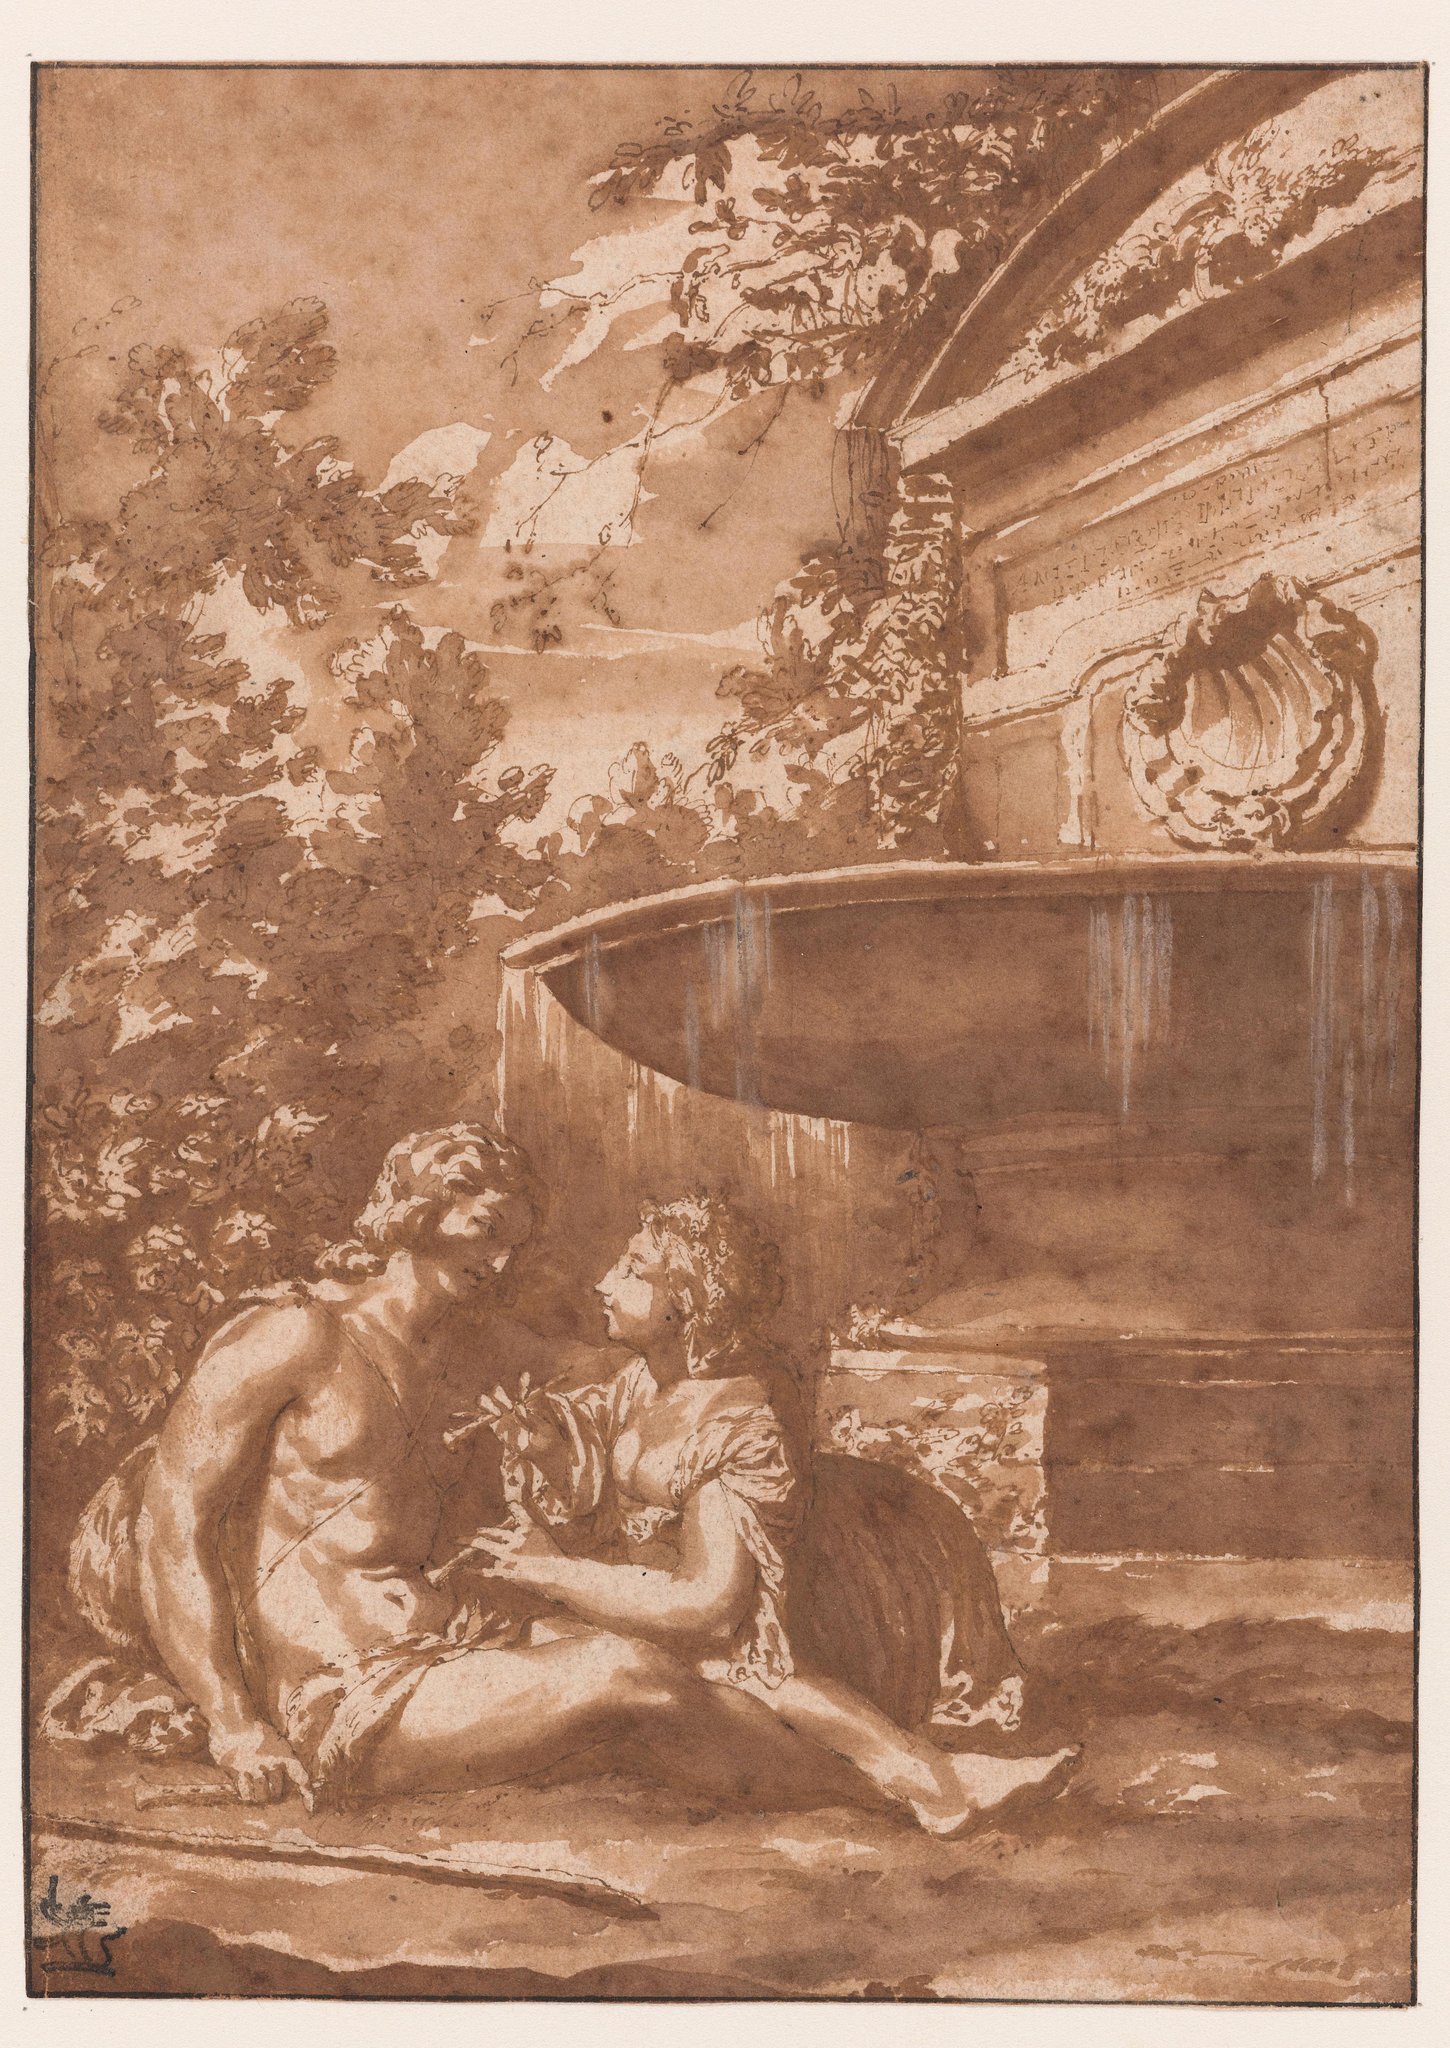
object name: drawing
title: Idylle bij een fontein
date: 1667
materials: ink, paper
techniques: brush, pen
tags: herding, herdsman, herdswoman, shepherd, shepherdess, cowherd, etc., ornamental fountain, utilitarian, public pump or water fountain, pastorals, arcadian scenes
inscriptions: date: ‘19. Mart: 1667’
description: Idylle van een in dierenvel geklede herder met een meisje bij een grote stenen fontein tussen geboomte. Ontwerp voor een prent.